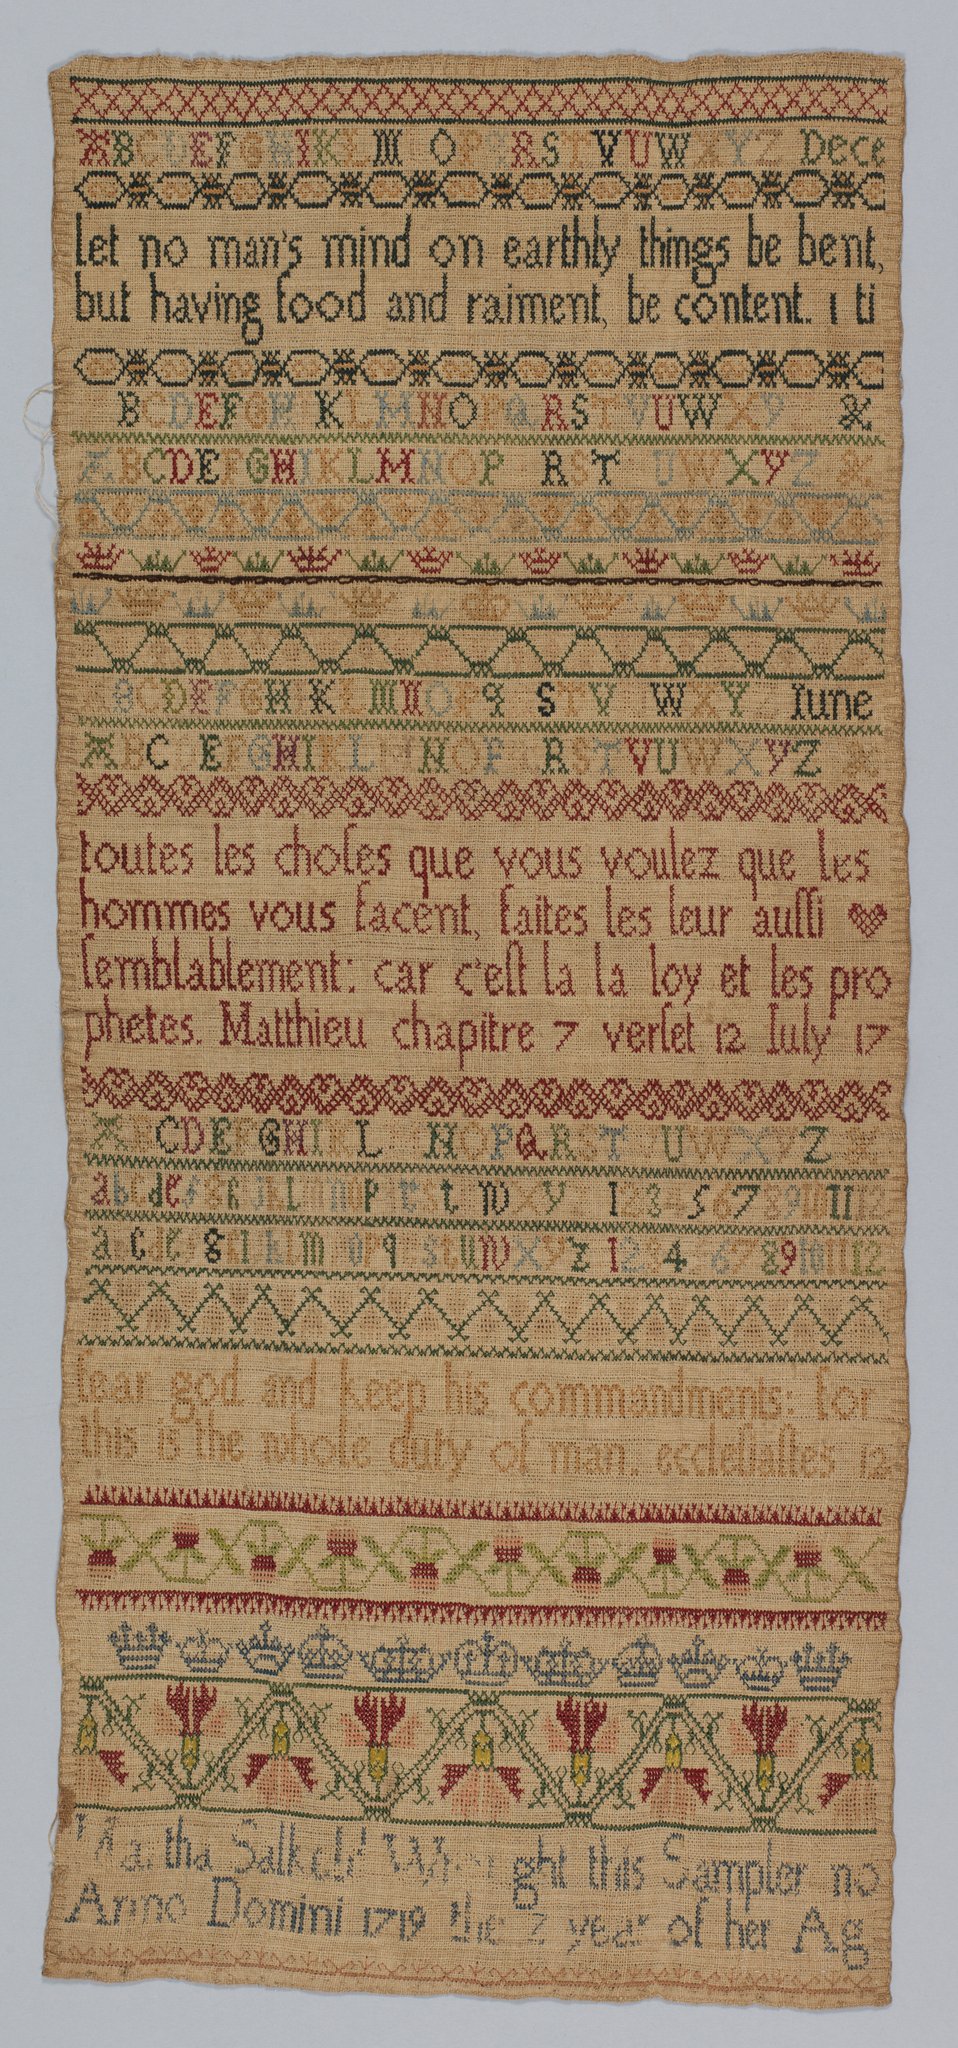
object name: sampler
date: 1719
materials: linen, silk